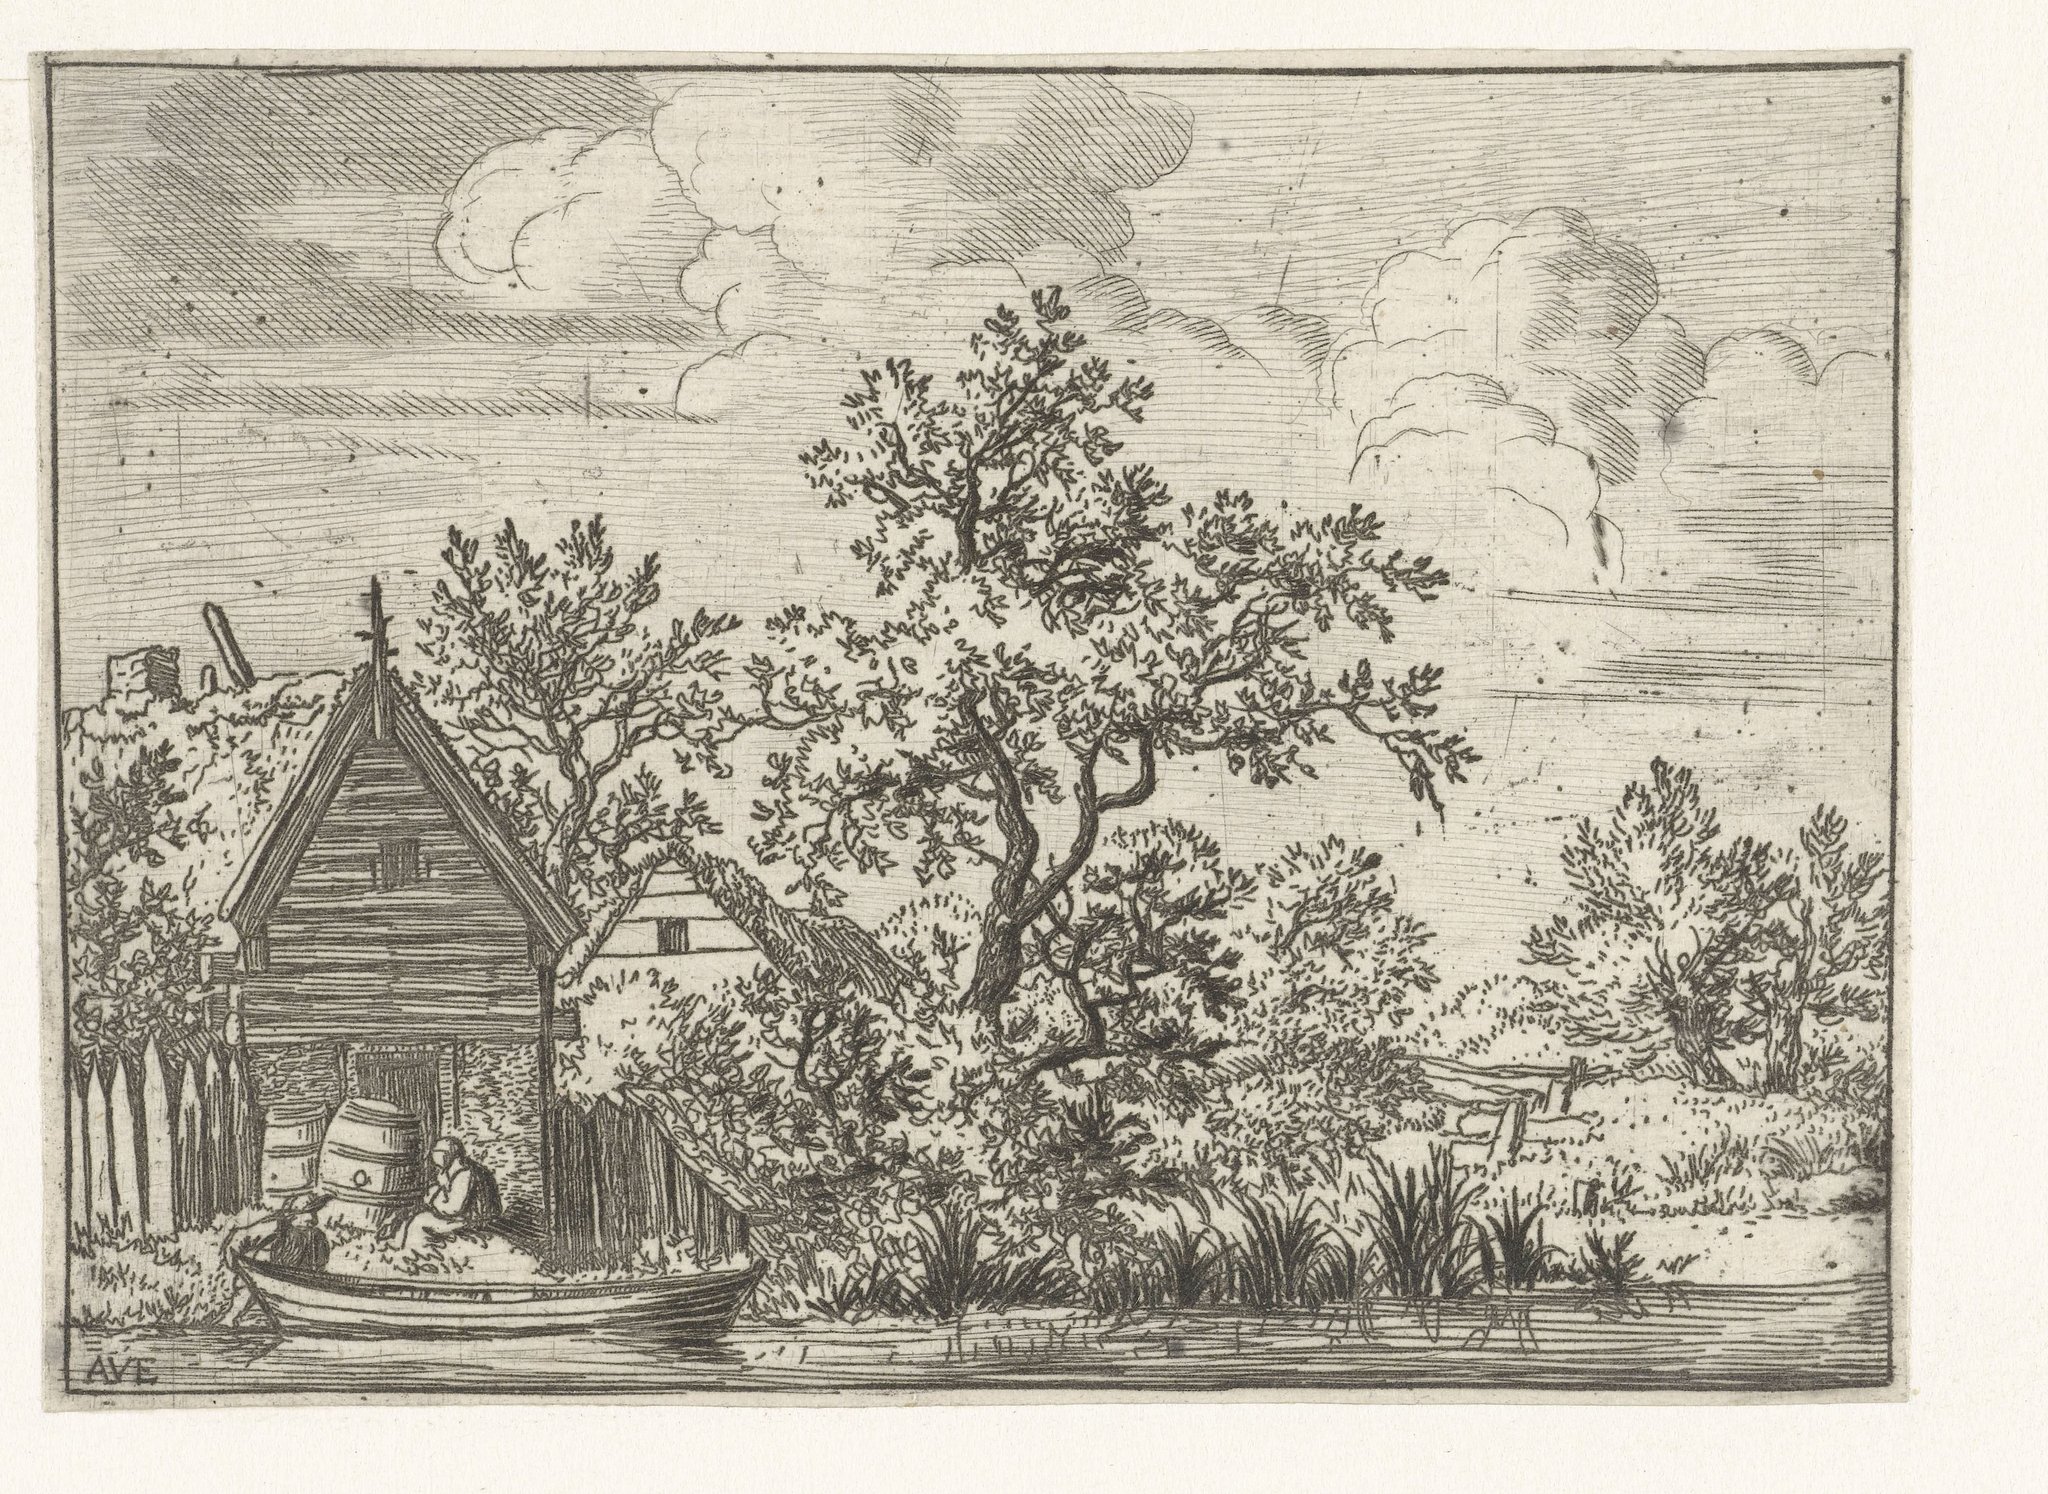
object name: print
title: Landschap met twee huizen en een roeiboot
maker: allaert van everdingen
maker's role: draughtsman, painter, print maker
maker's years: 1621-1675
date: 1631-1675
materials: paper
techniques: etching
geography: netherlands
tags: river (+ landscape with figures, staffage)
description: Landschap met twee huizen tussen bomen en struikgewas. Langs het water zit een persoon naast twee tonnen en op de voorgrond duwt een tweede persoon een roeiboot voort.